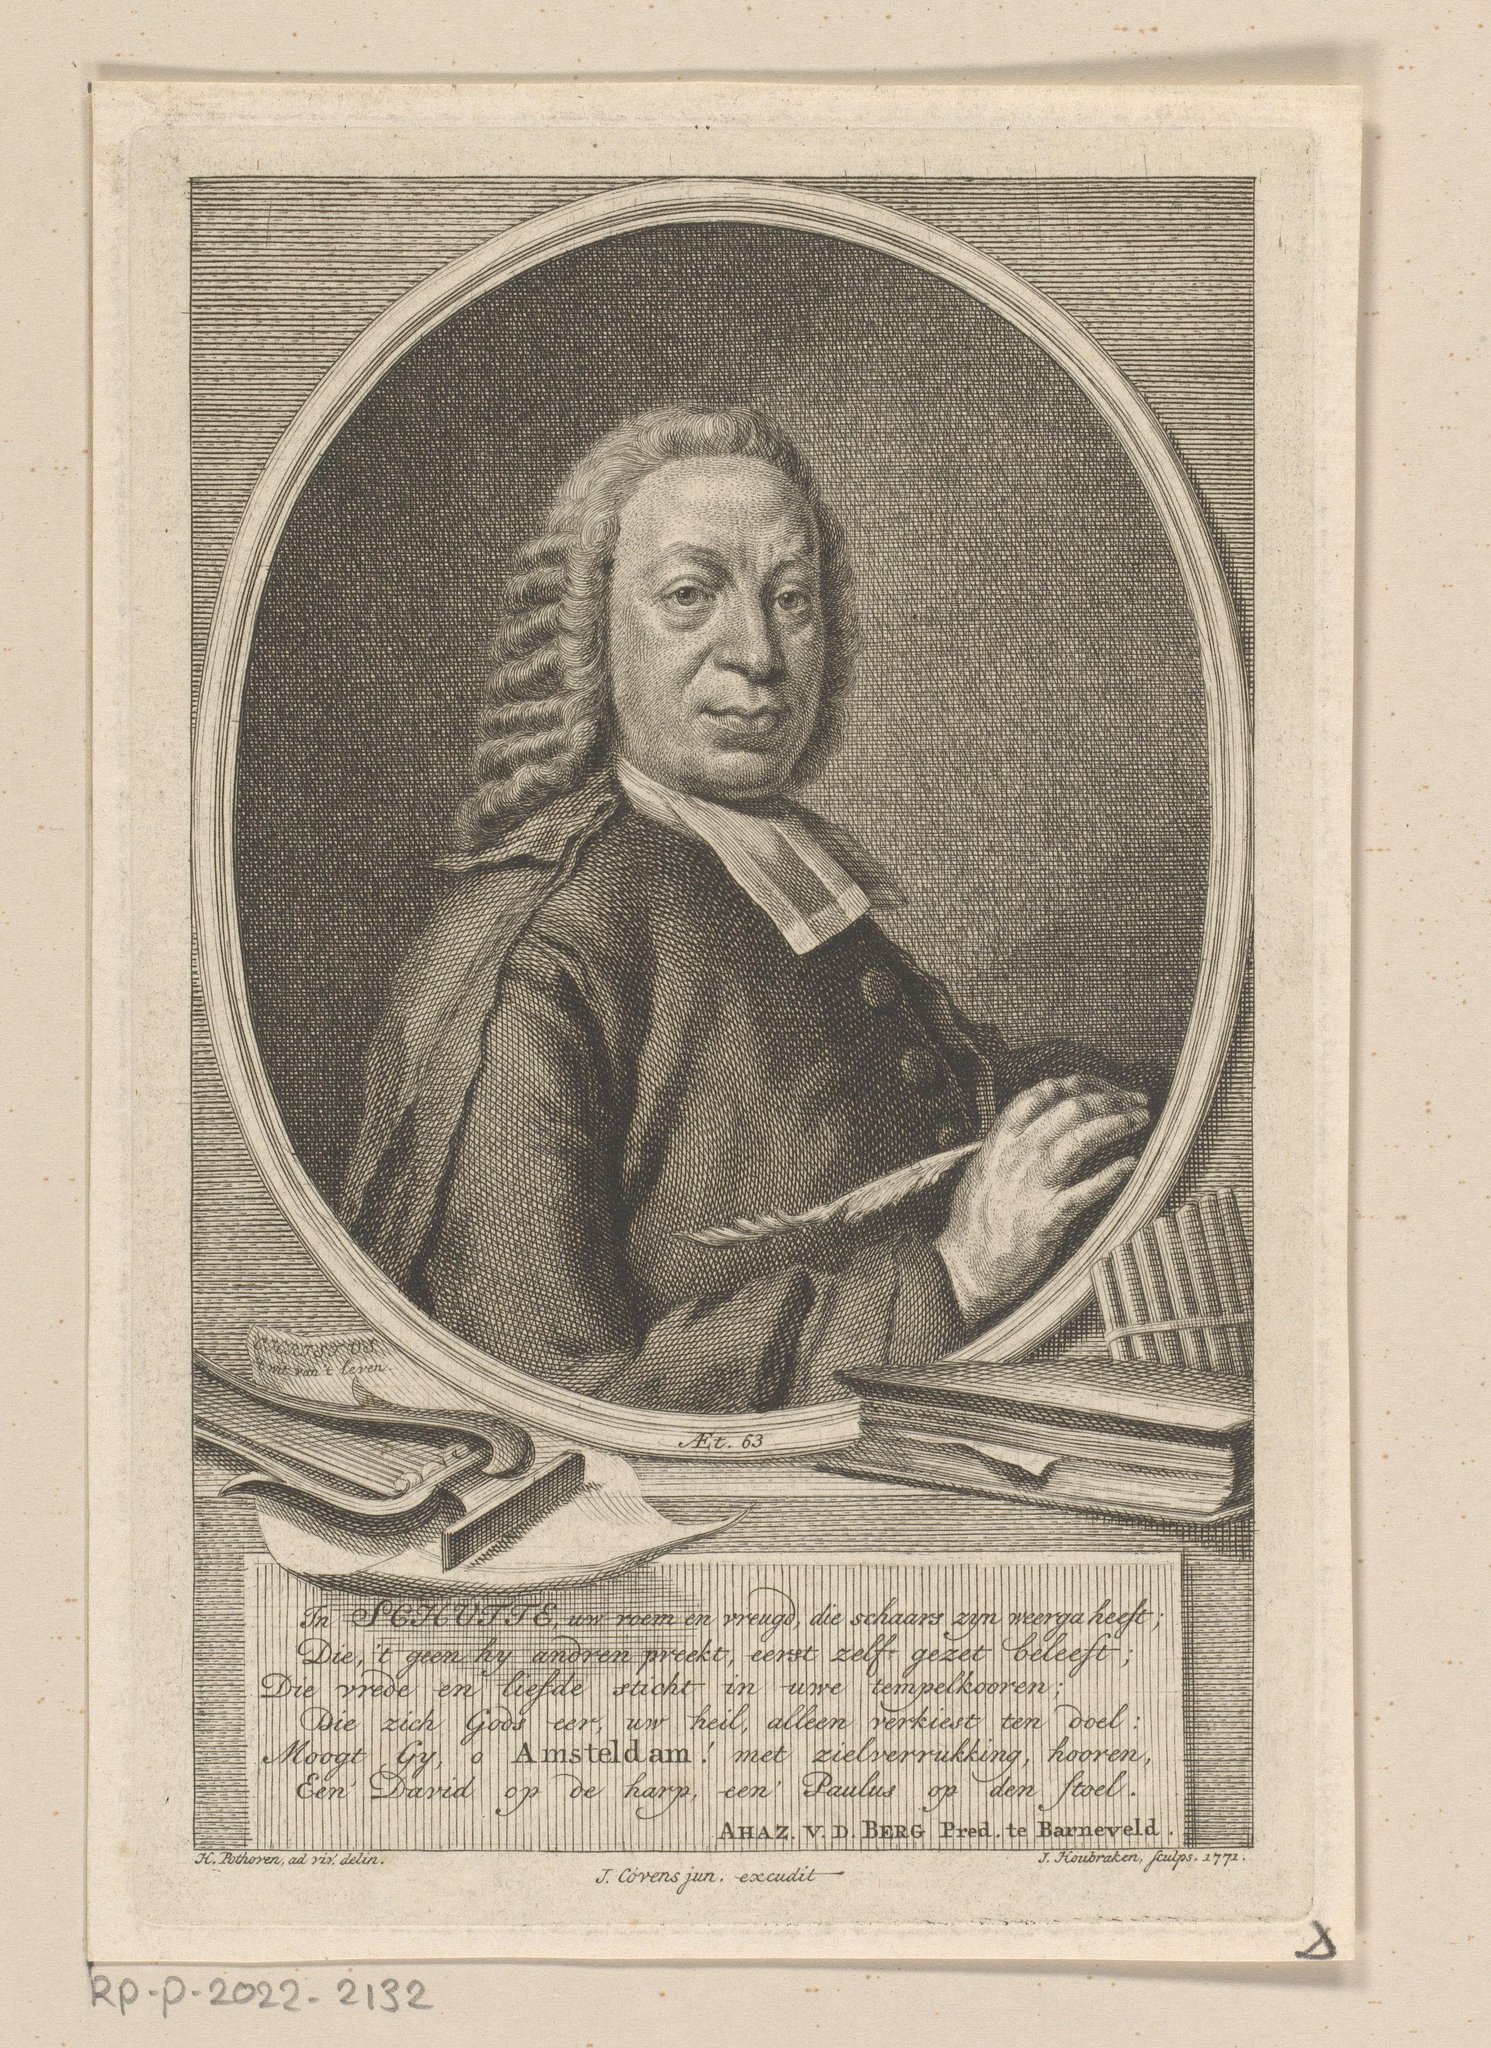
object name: print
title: Portret van Rutger Schutte op 63-jarige leeftijd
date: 1771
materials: paper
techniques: engraving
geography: amsterdam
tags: amsterdam, rutger schutte, historical persons, portrait of a writer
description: Prent waarschijnlijk uit: Schutte, Rutger. Stichtelyke gezangen, op de beste Italiaanschen, en eenige in dien smaak nieuwgemaakte zangwyzen (...). Amsterdam: Johannes Covens jr., 1770.